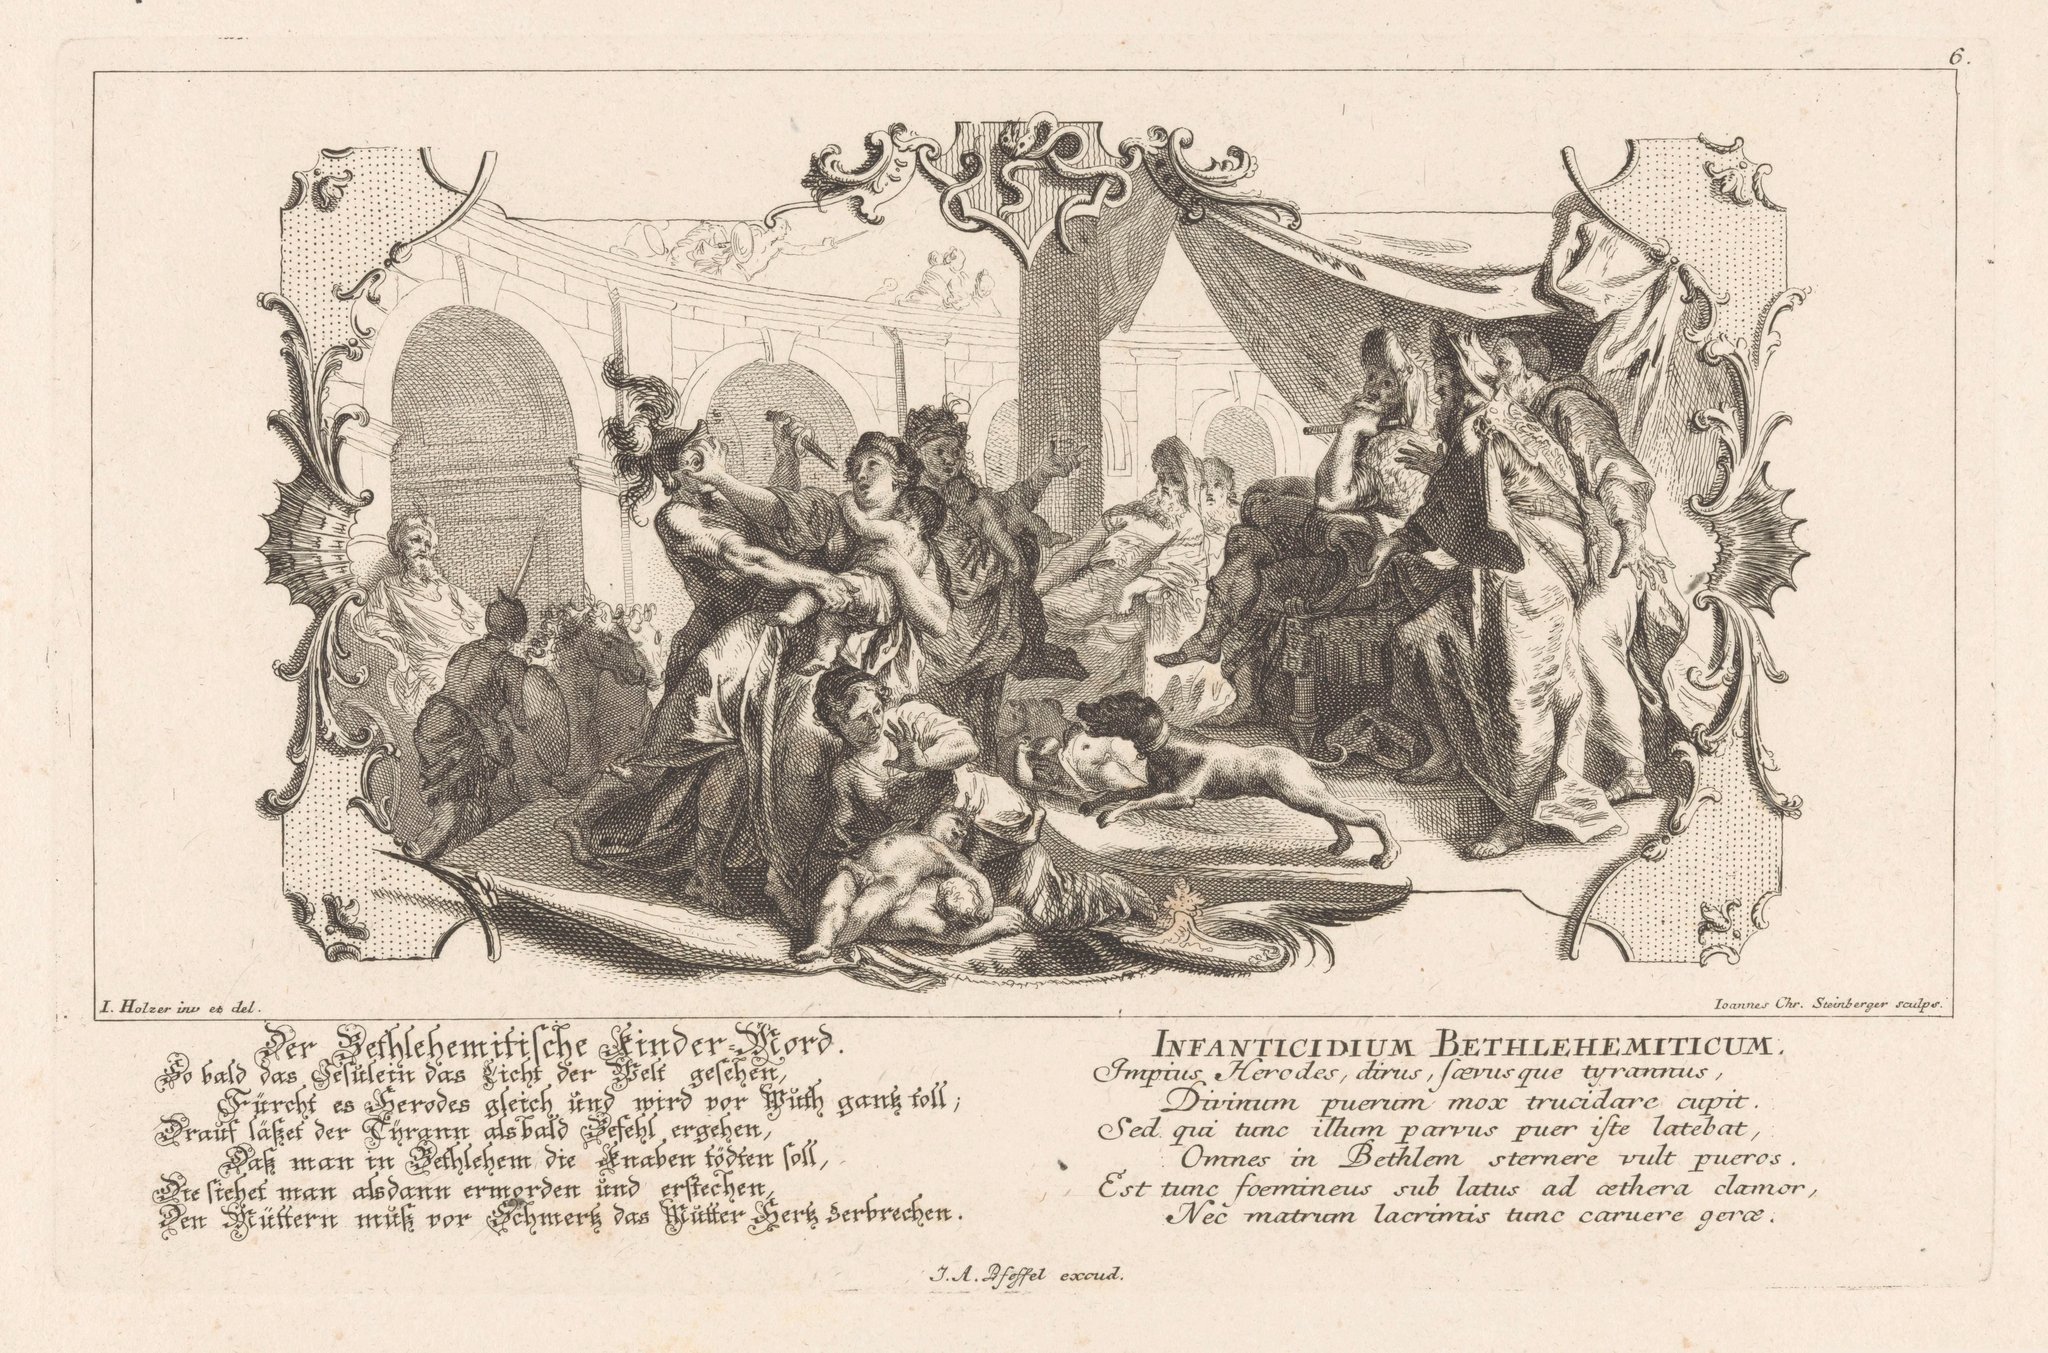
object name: print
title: Kindermoord te Bethlehem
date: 1719-1727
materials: paper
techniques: etching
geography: augsburg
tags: the massacre ot the innocents; sometimes herod looking on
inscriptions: collector's mark: Lugt 2760, collector's mark: Lugt 2228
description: De kindermoord te Bethlehem. Onder toeziend oog van koning Herodes, gezeten op zijn troon, worden pasgeboren kinderen door soldaten gedood. Tevergeefs proberen moeders hun zonen te beschermen. Rondom de voorstelling een rocaille omlijsting. In de ondermarge tweemaal een zevenregelige Duitse en Latijnse tekst.